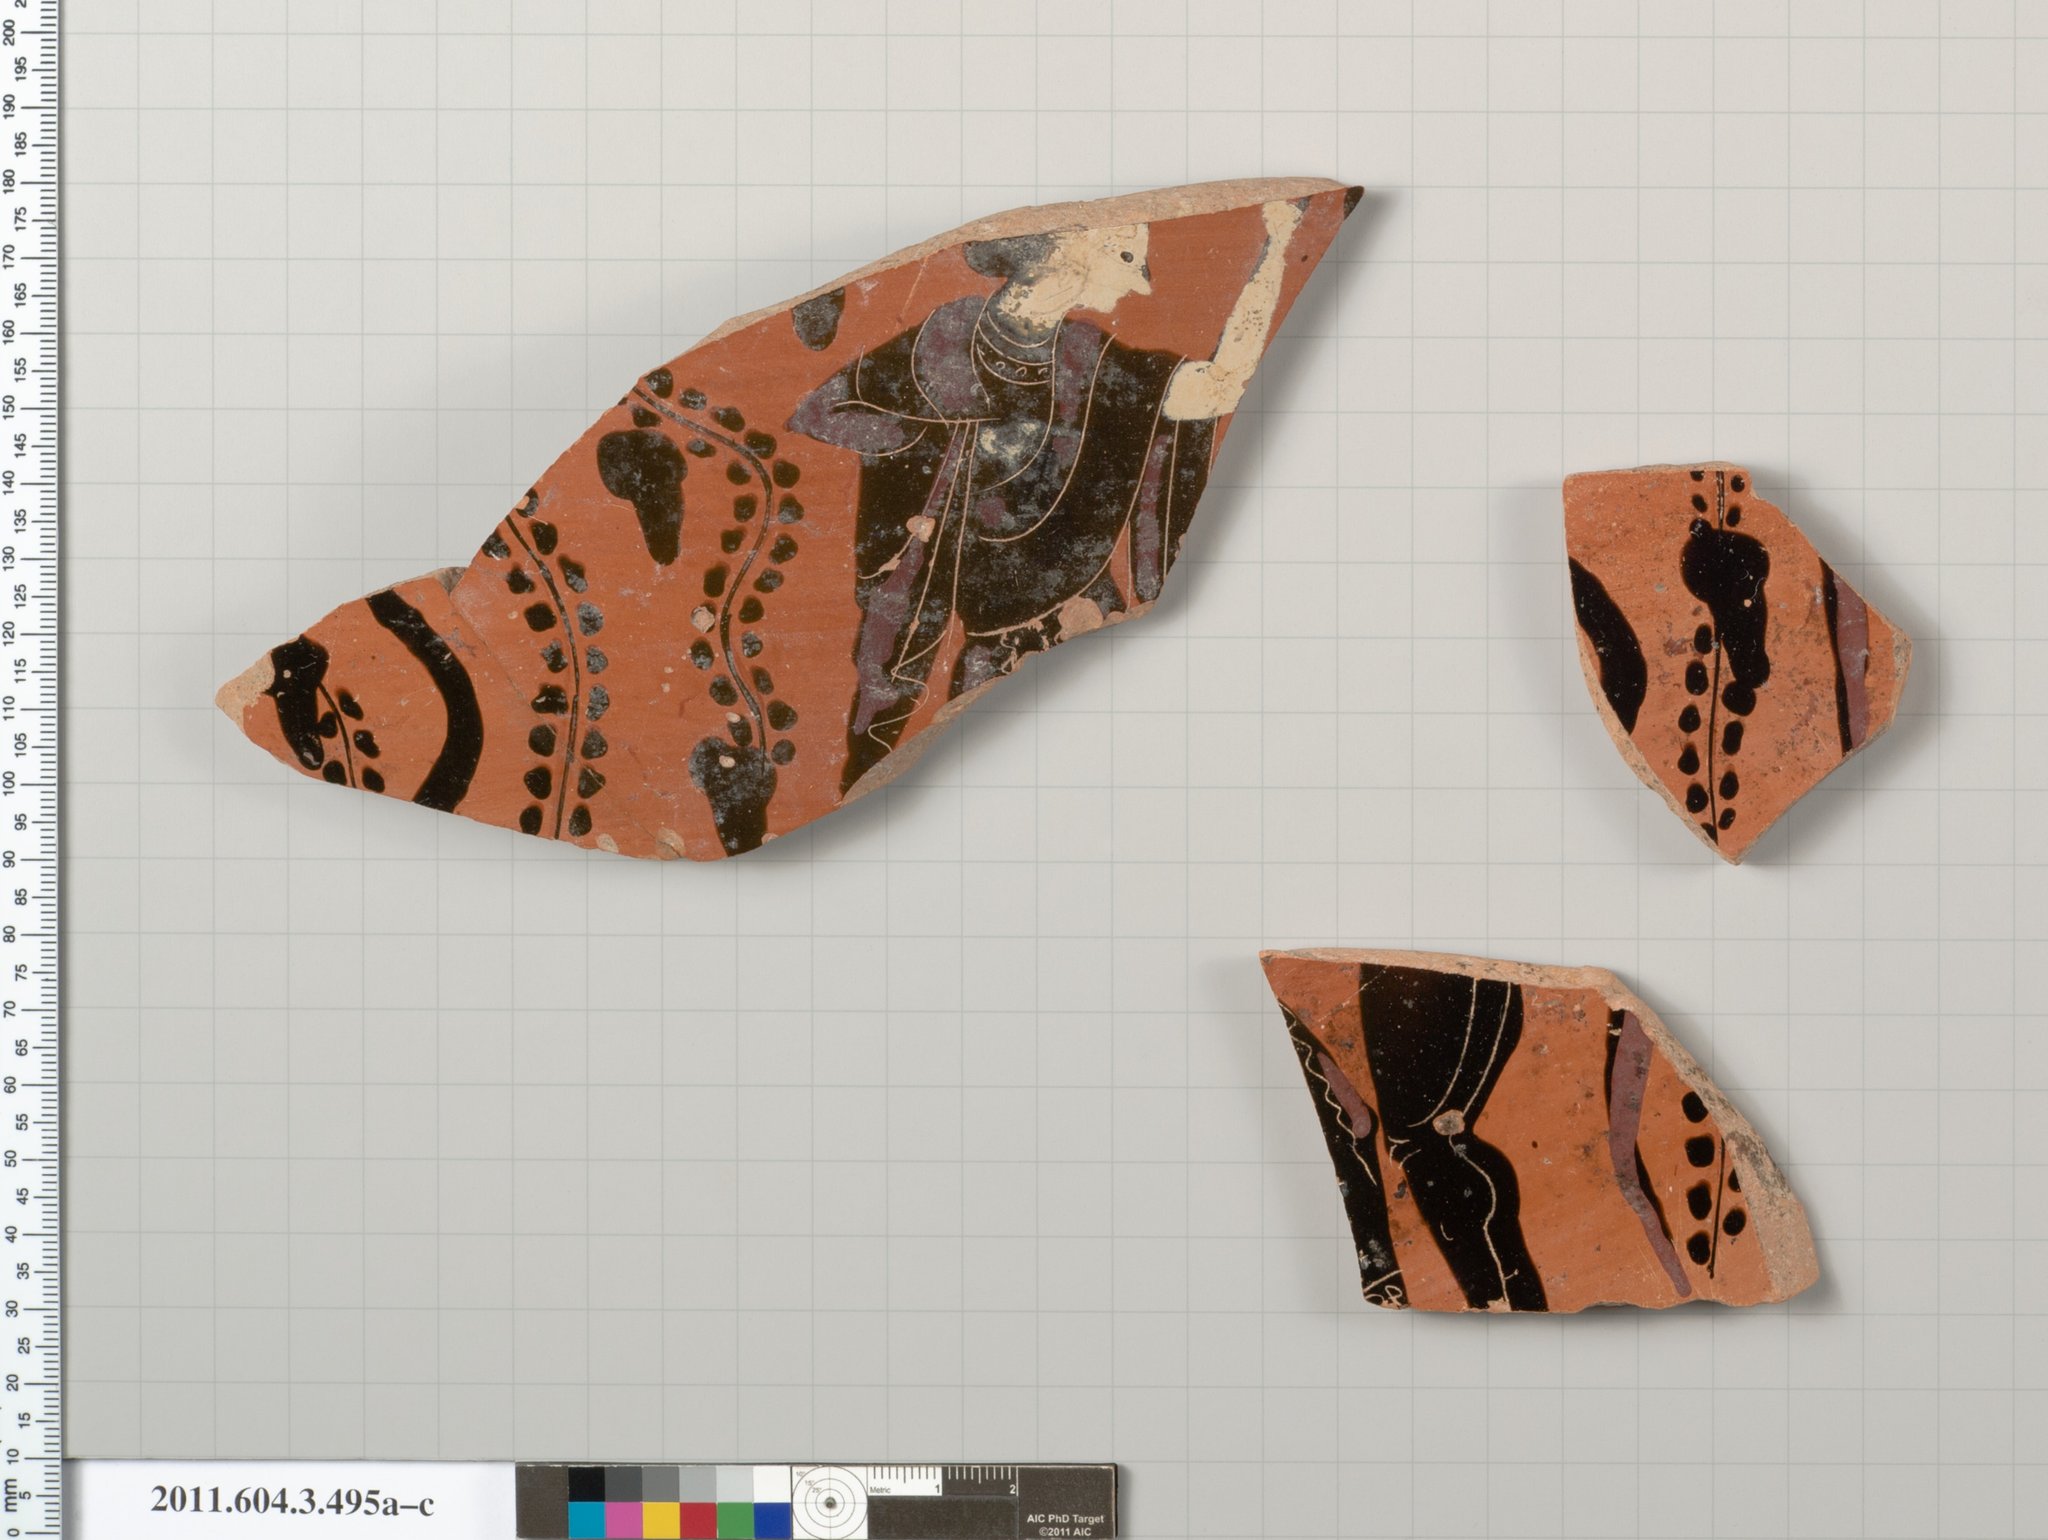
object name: column krater fragment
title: Terracotta fragments of a column-krater (bowl for mixing wine and water)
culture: greek, attic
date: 550-526 BCE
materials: terracotta